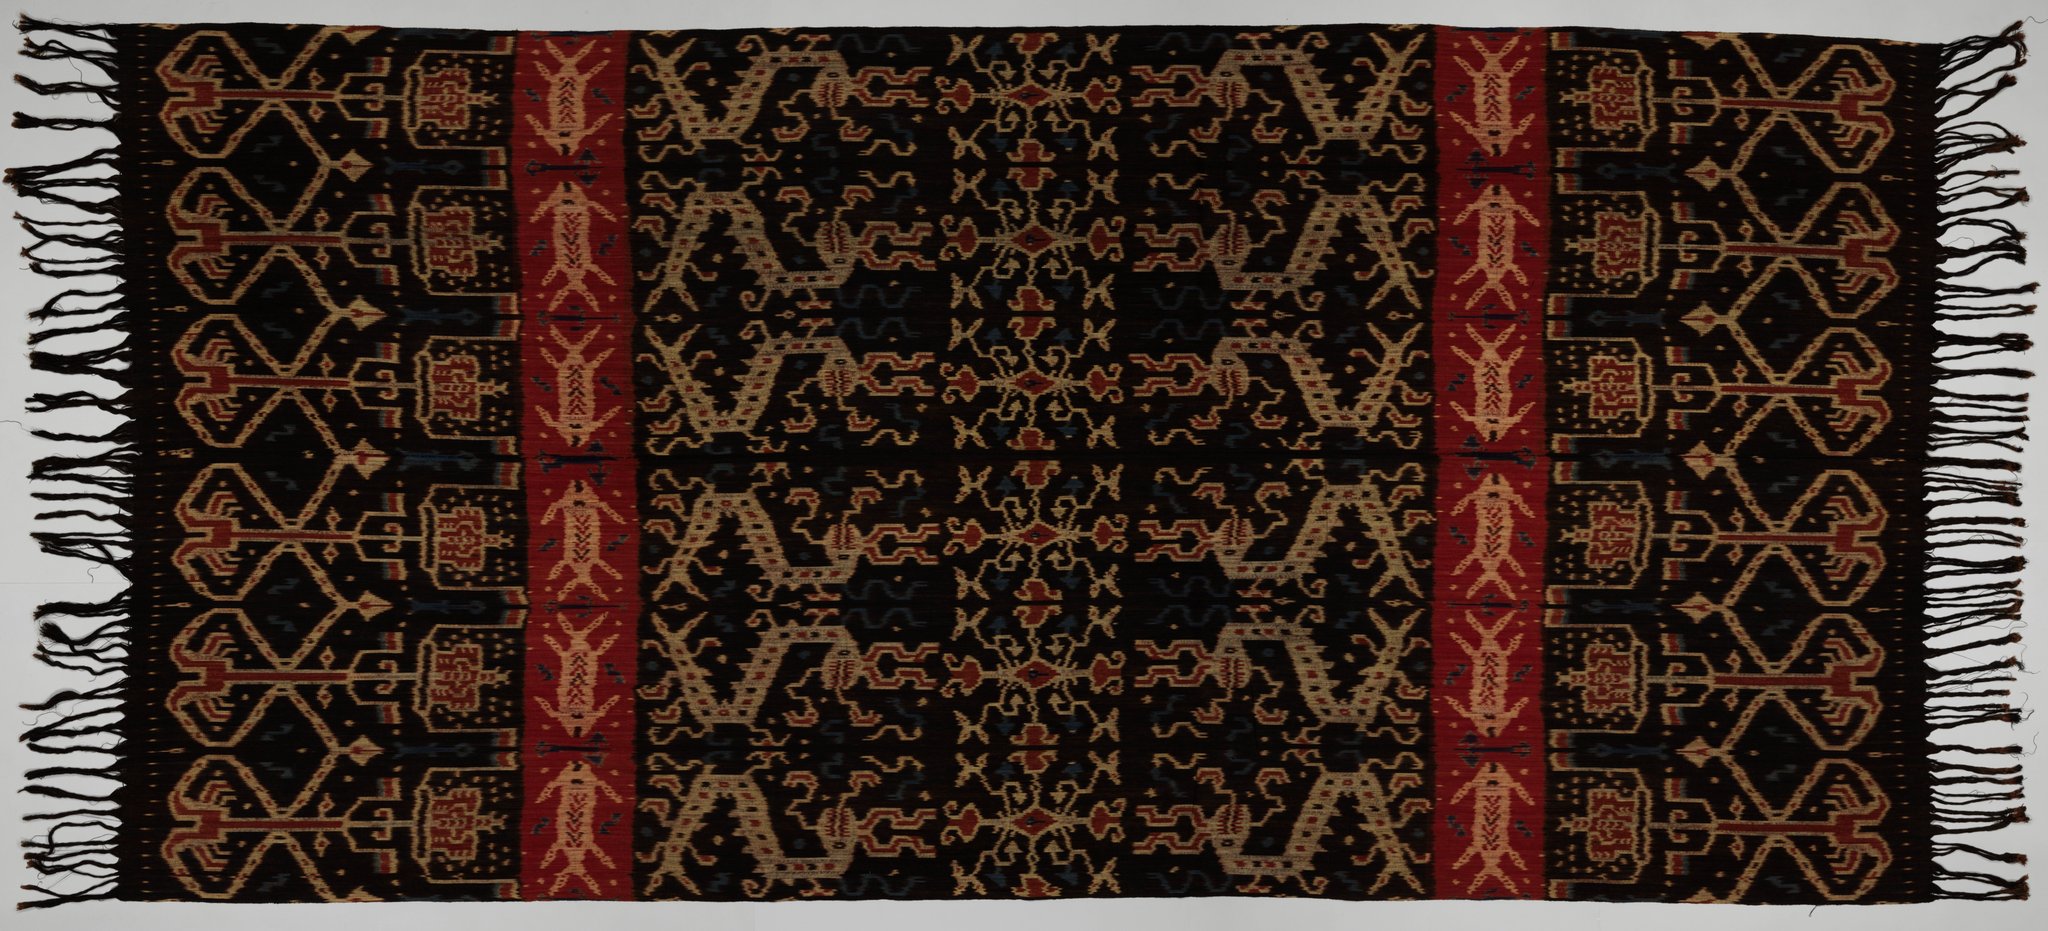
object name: omslagdoek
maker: Anonymous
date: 1900-1949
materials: cotton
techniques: weave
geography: soemba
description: Omslagdoek met heraldische leeuwen, slangen en patola motieven.